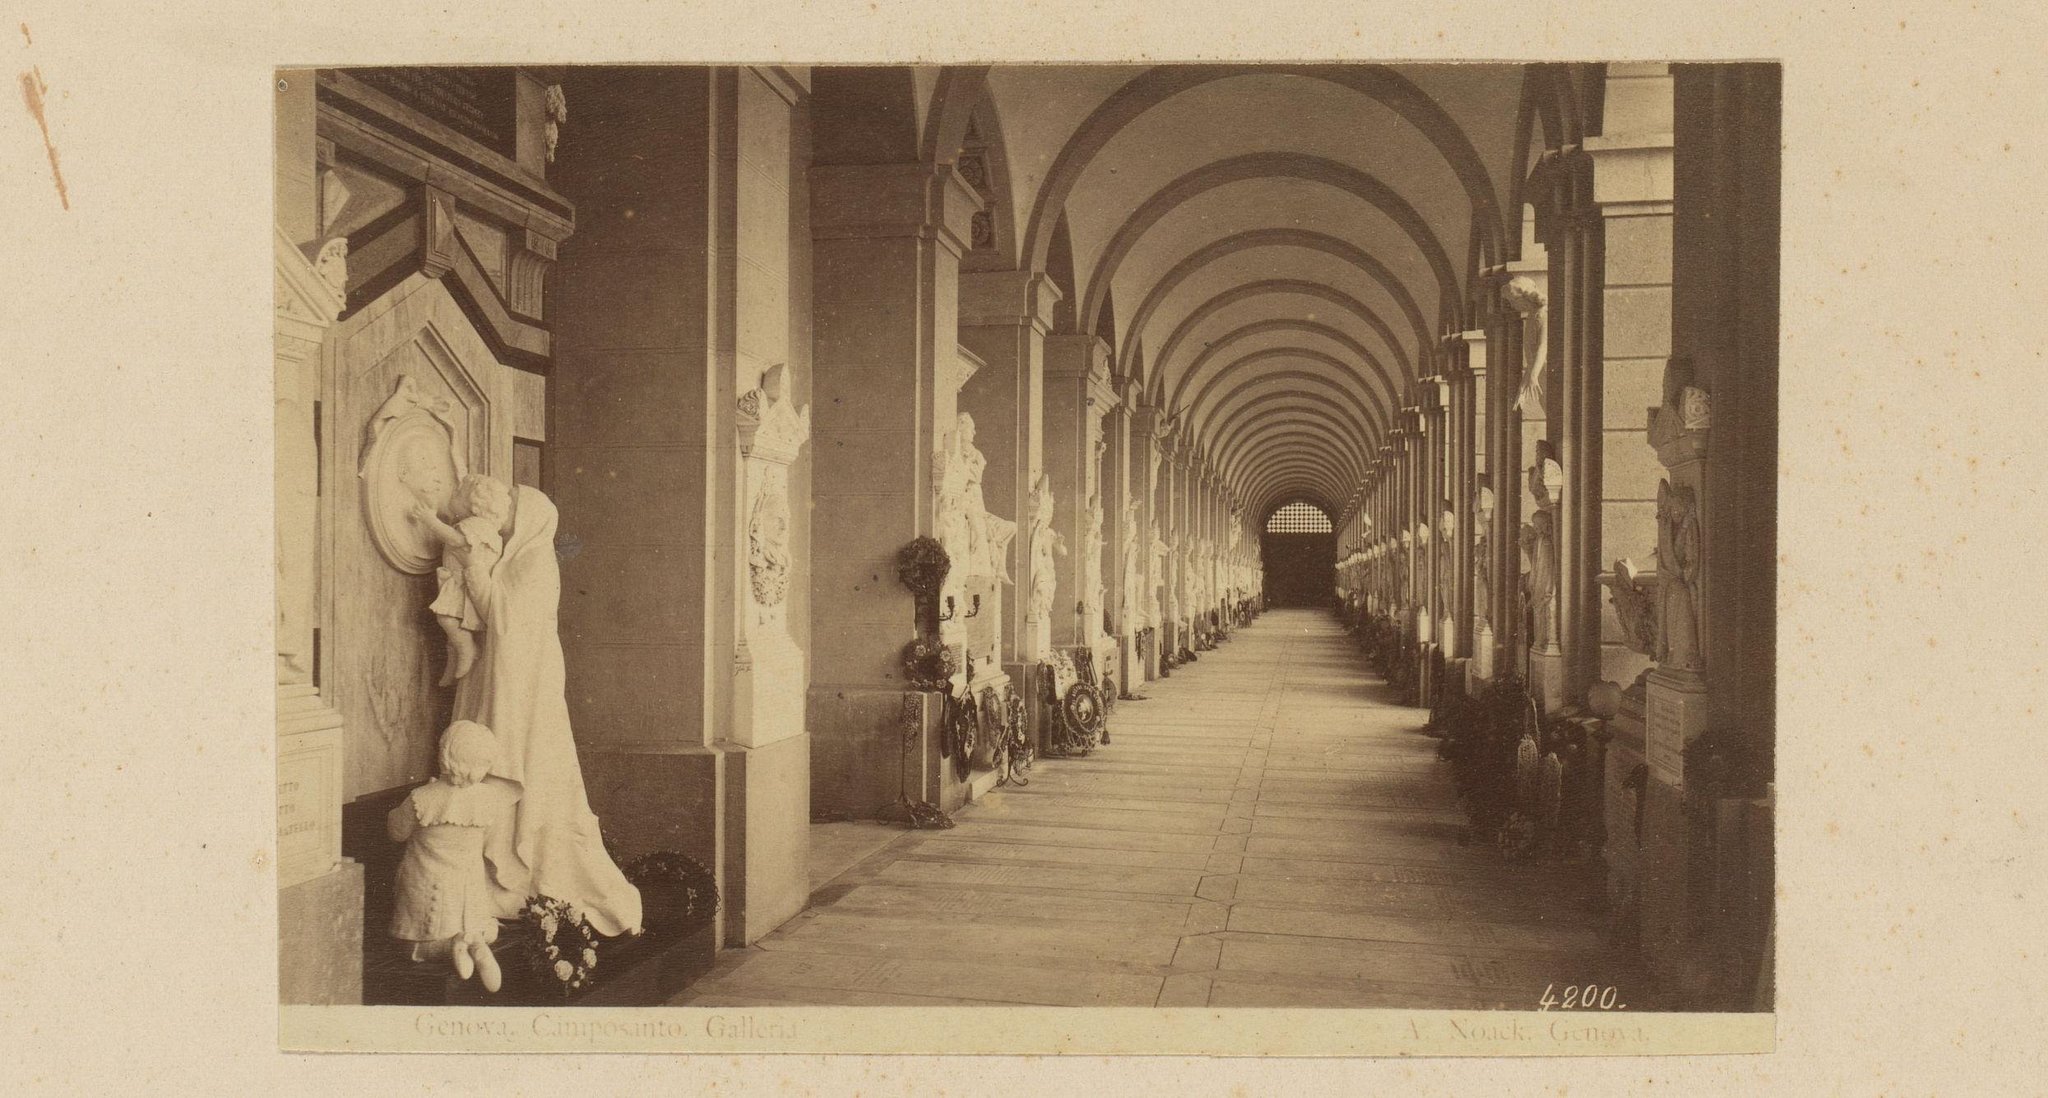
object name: photograph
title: Galerij in het Camposanto te Genua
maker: alfredo noack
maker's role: fotograaf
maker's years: 1833-1895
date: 1891-1900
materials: paper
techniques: albumen print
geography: genoa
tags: gallery (spacious corridor), grave-building, monumental tomb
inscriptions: number: ‘4200.’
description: Deze foto zat oorspronkelijk in prentenkabinet RP-F-AA3192.